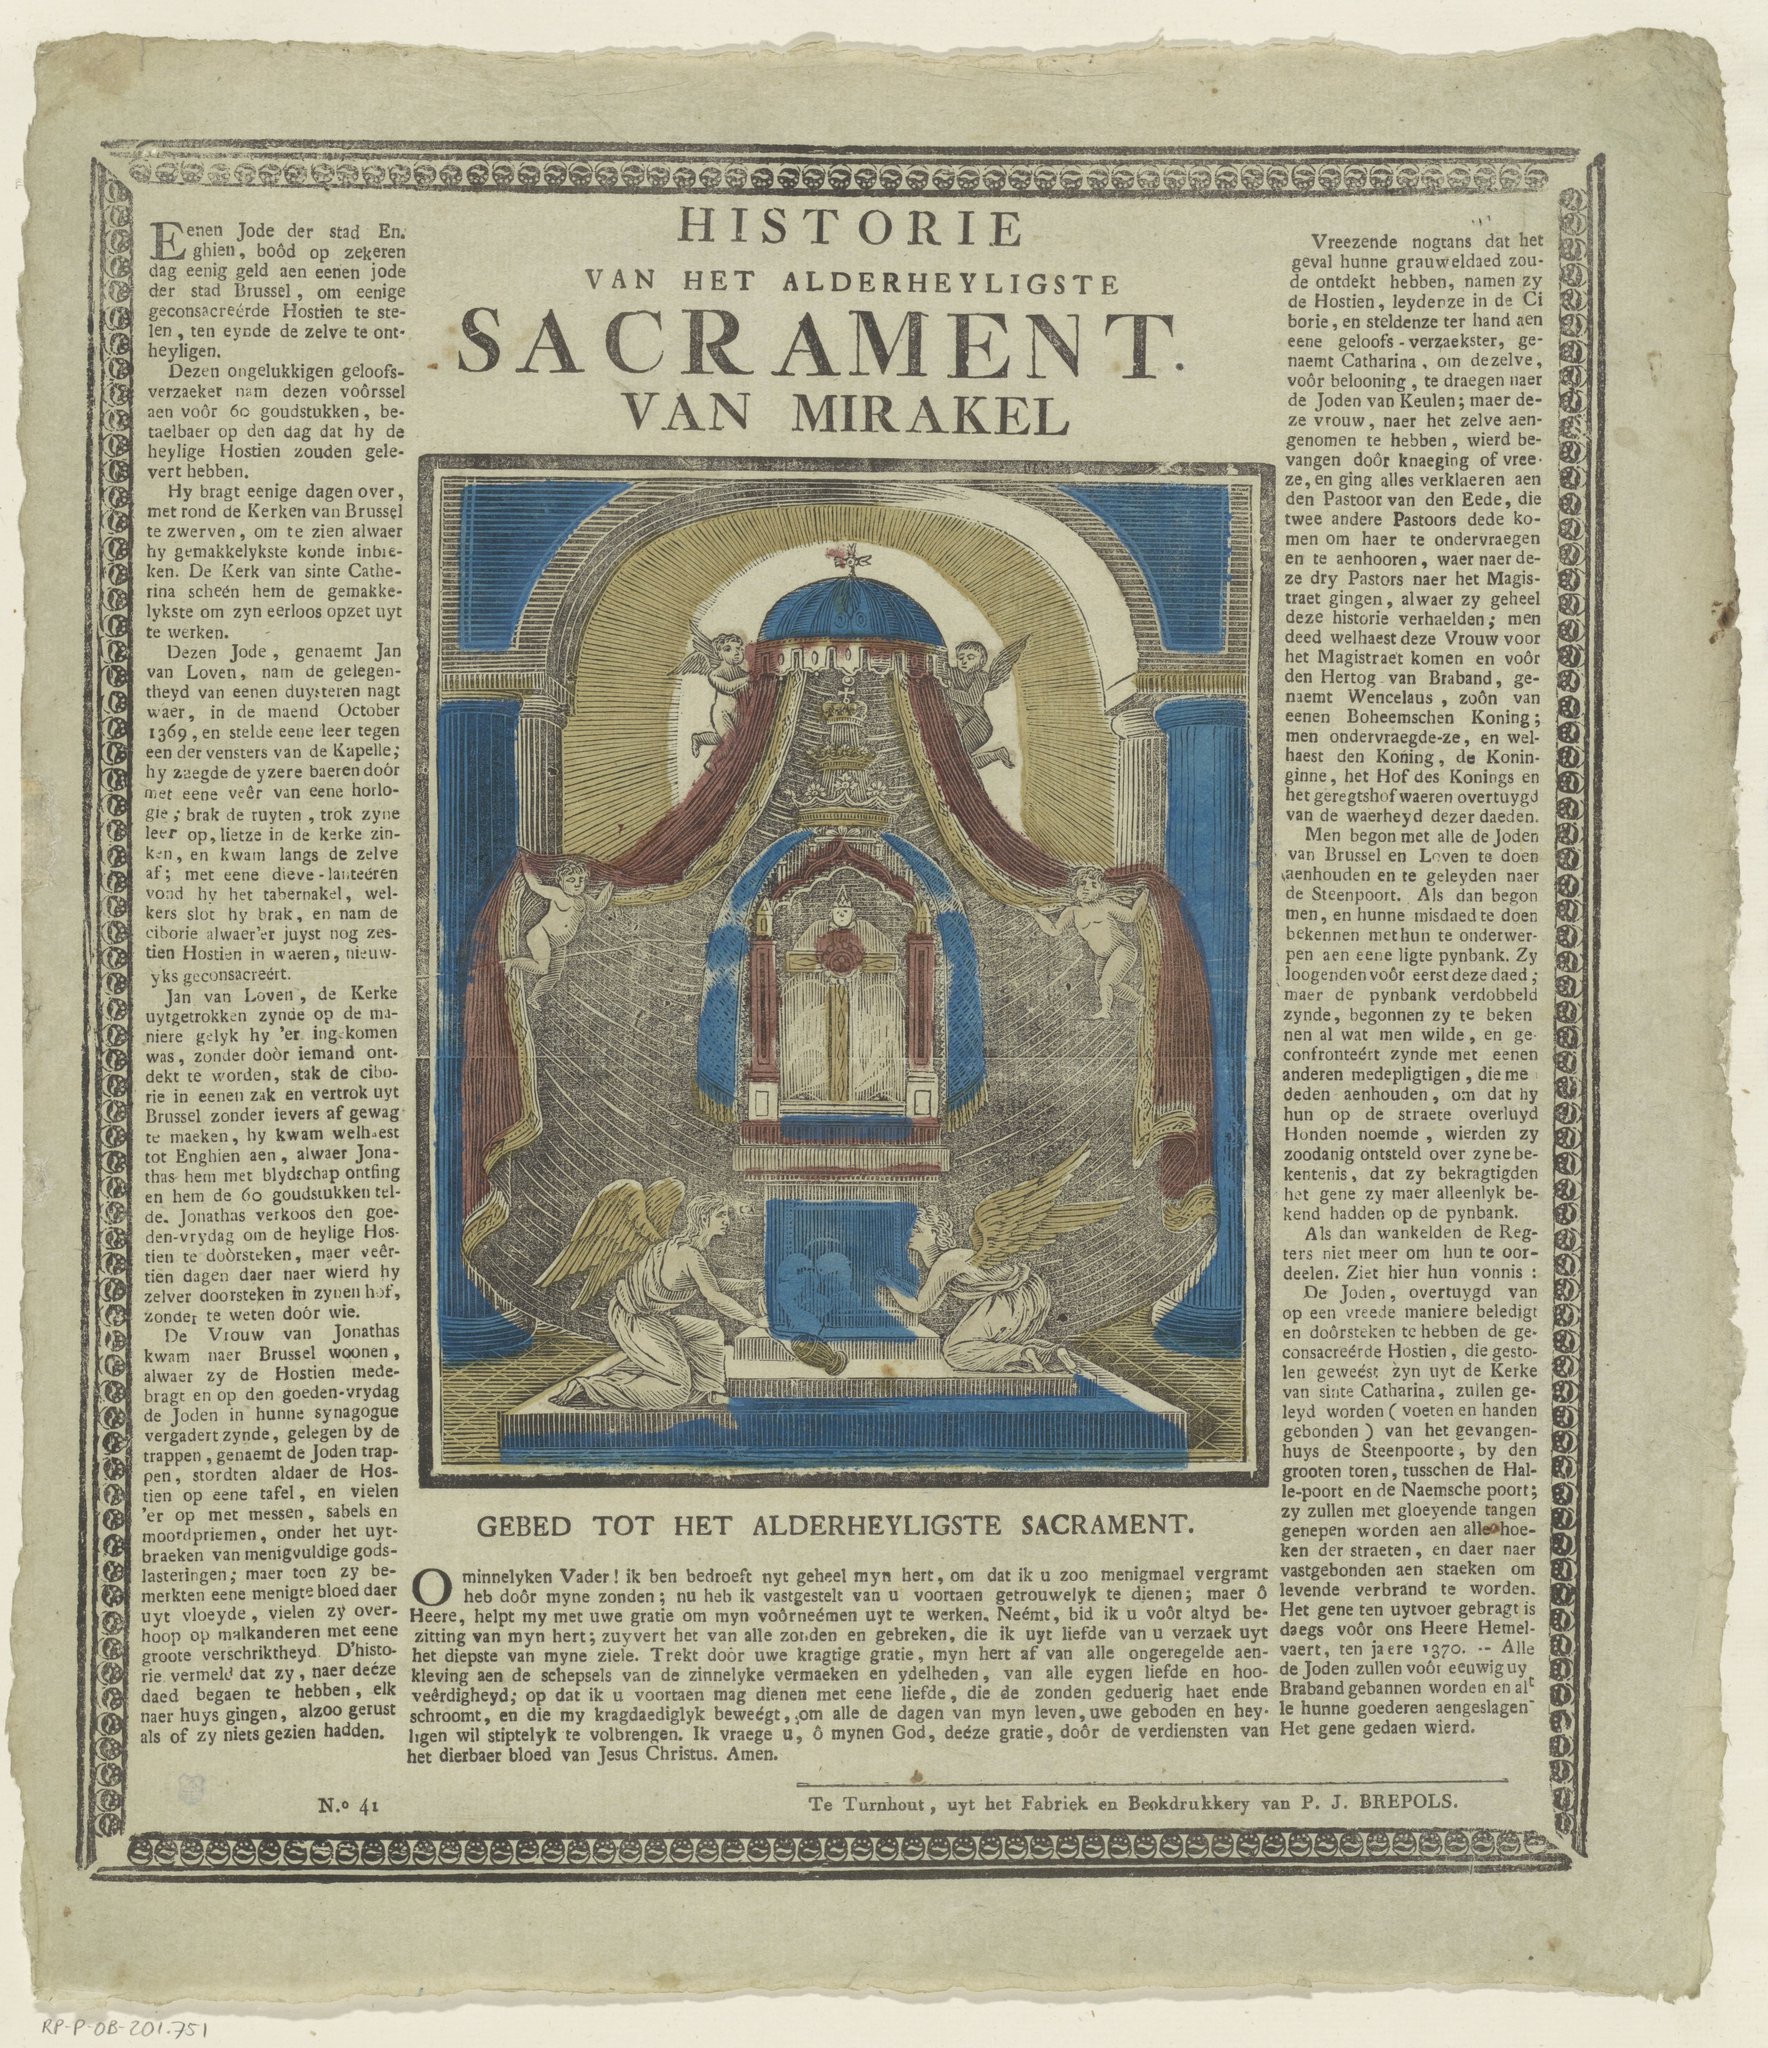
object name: print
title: Historie / van het alderheyligste / sacrament / van mirakel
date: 1800-1833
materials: paper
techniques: colour, letterpress printing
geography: turnhout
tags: tabernacle ~ altar, cupids: 'amores', 'amoretti', 'putti'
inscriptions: collector's mark: Lugt 2760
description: Een tabernakel onder een baldakijn. Putti houden de gordijnen van het baldakijn geopend. Rondom tekst in boekdruk in het Nederlands. Geheel omgeven door een sierrand. Genummerd linksonder: No. 41.